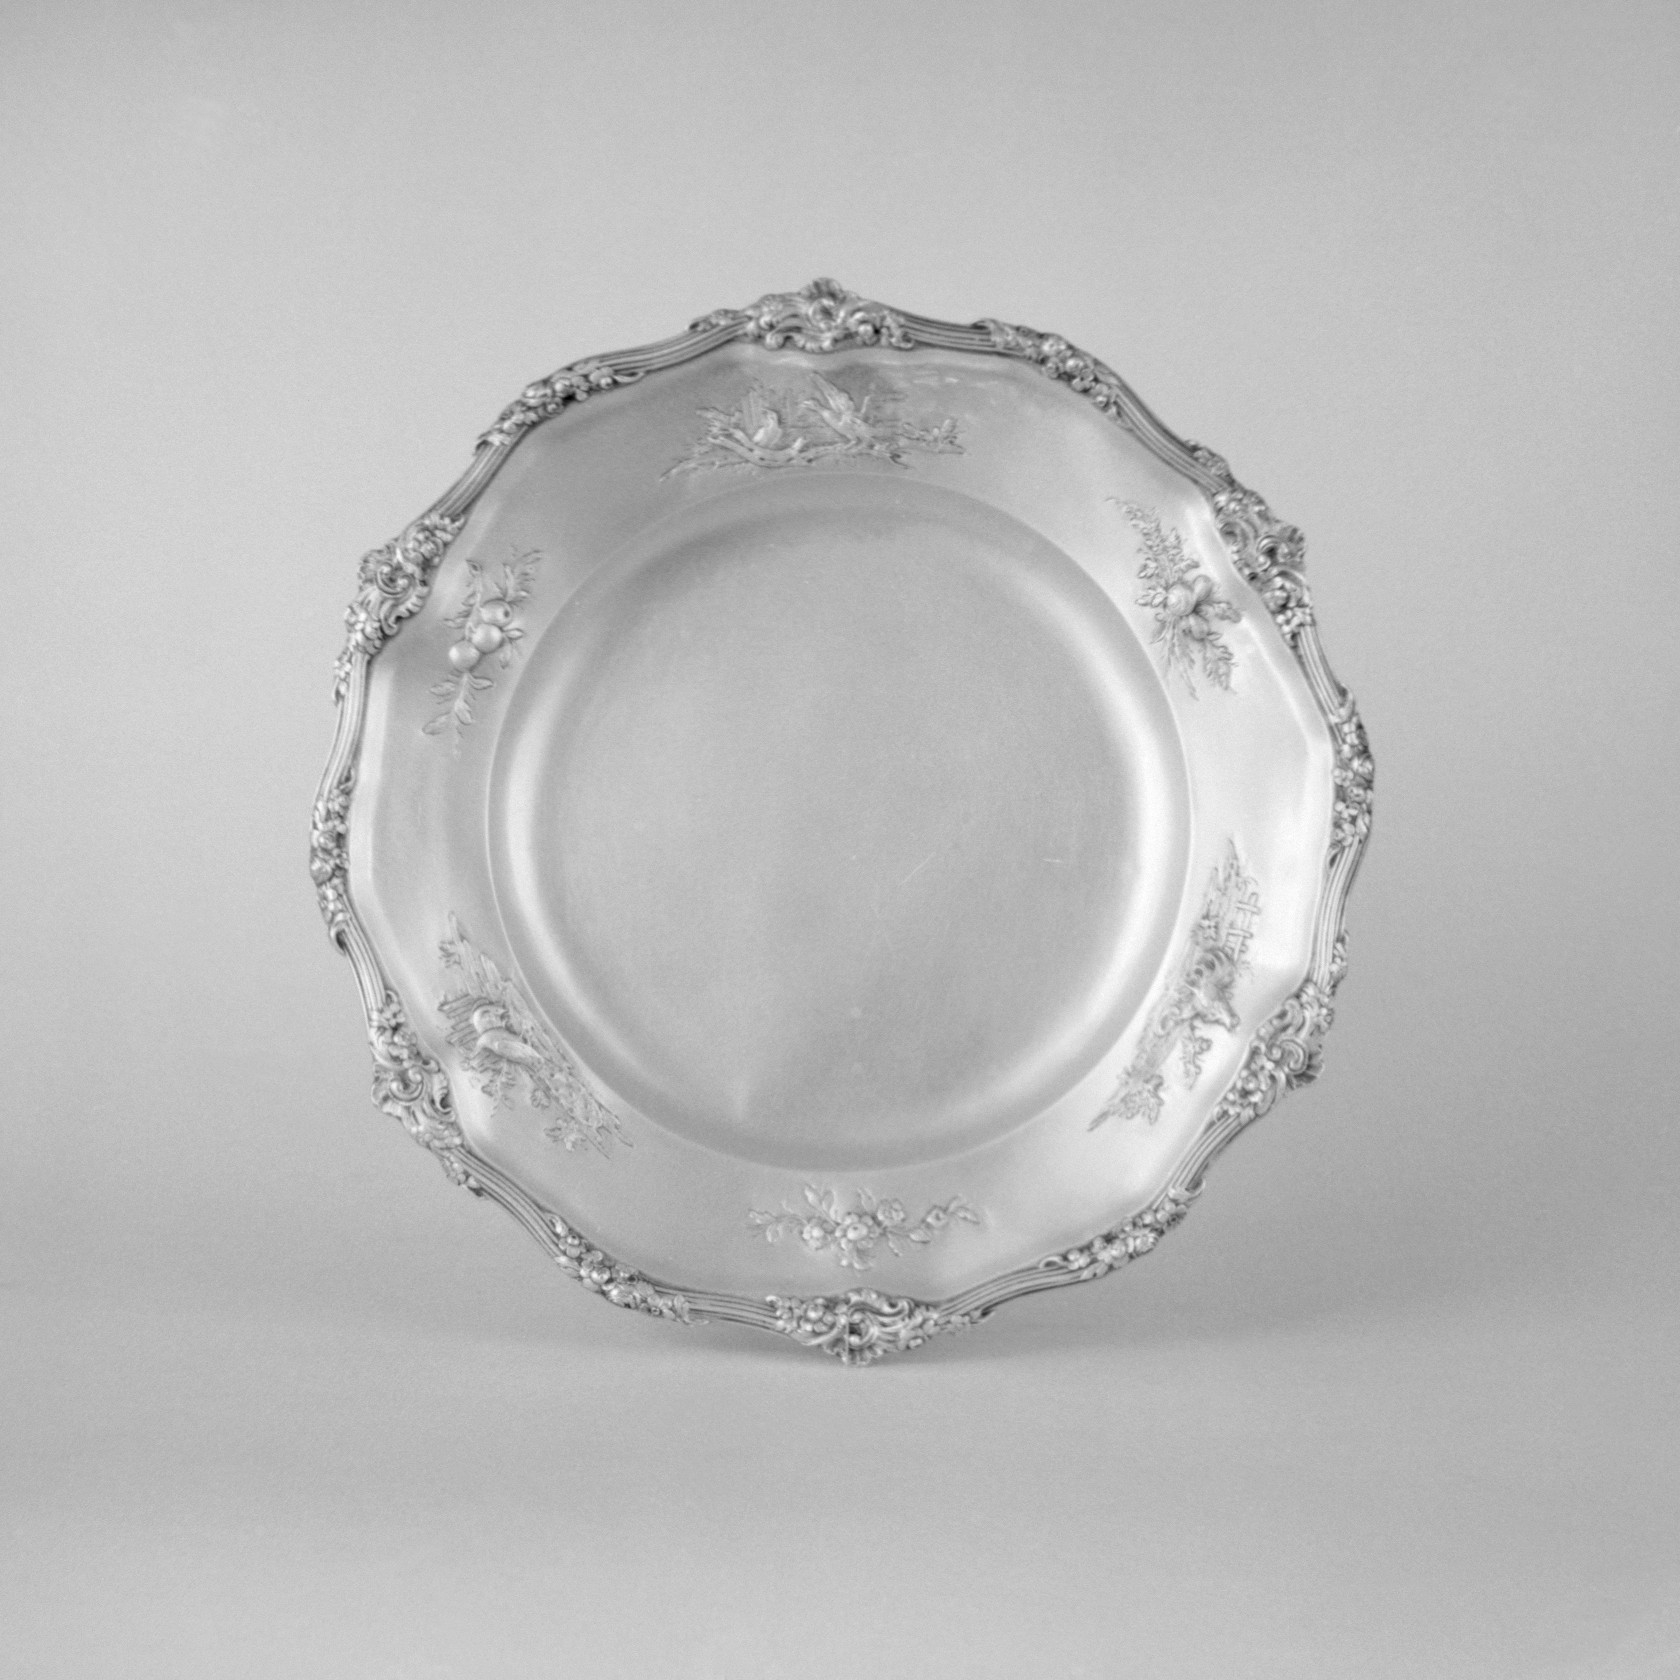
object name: plate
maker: abraham drentwett iv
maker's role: maker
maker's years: 1711-1785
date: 1769-1771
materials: silver gilt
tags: birds,fruit,flowers